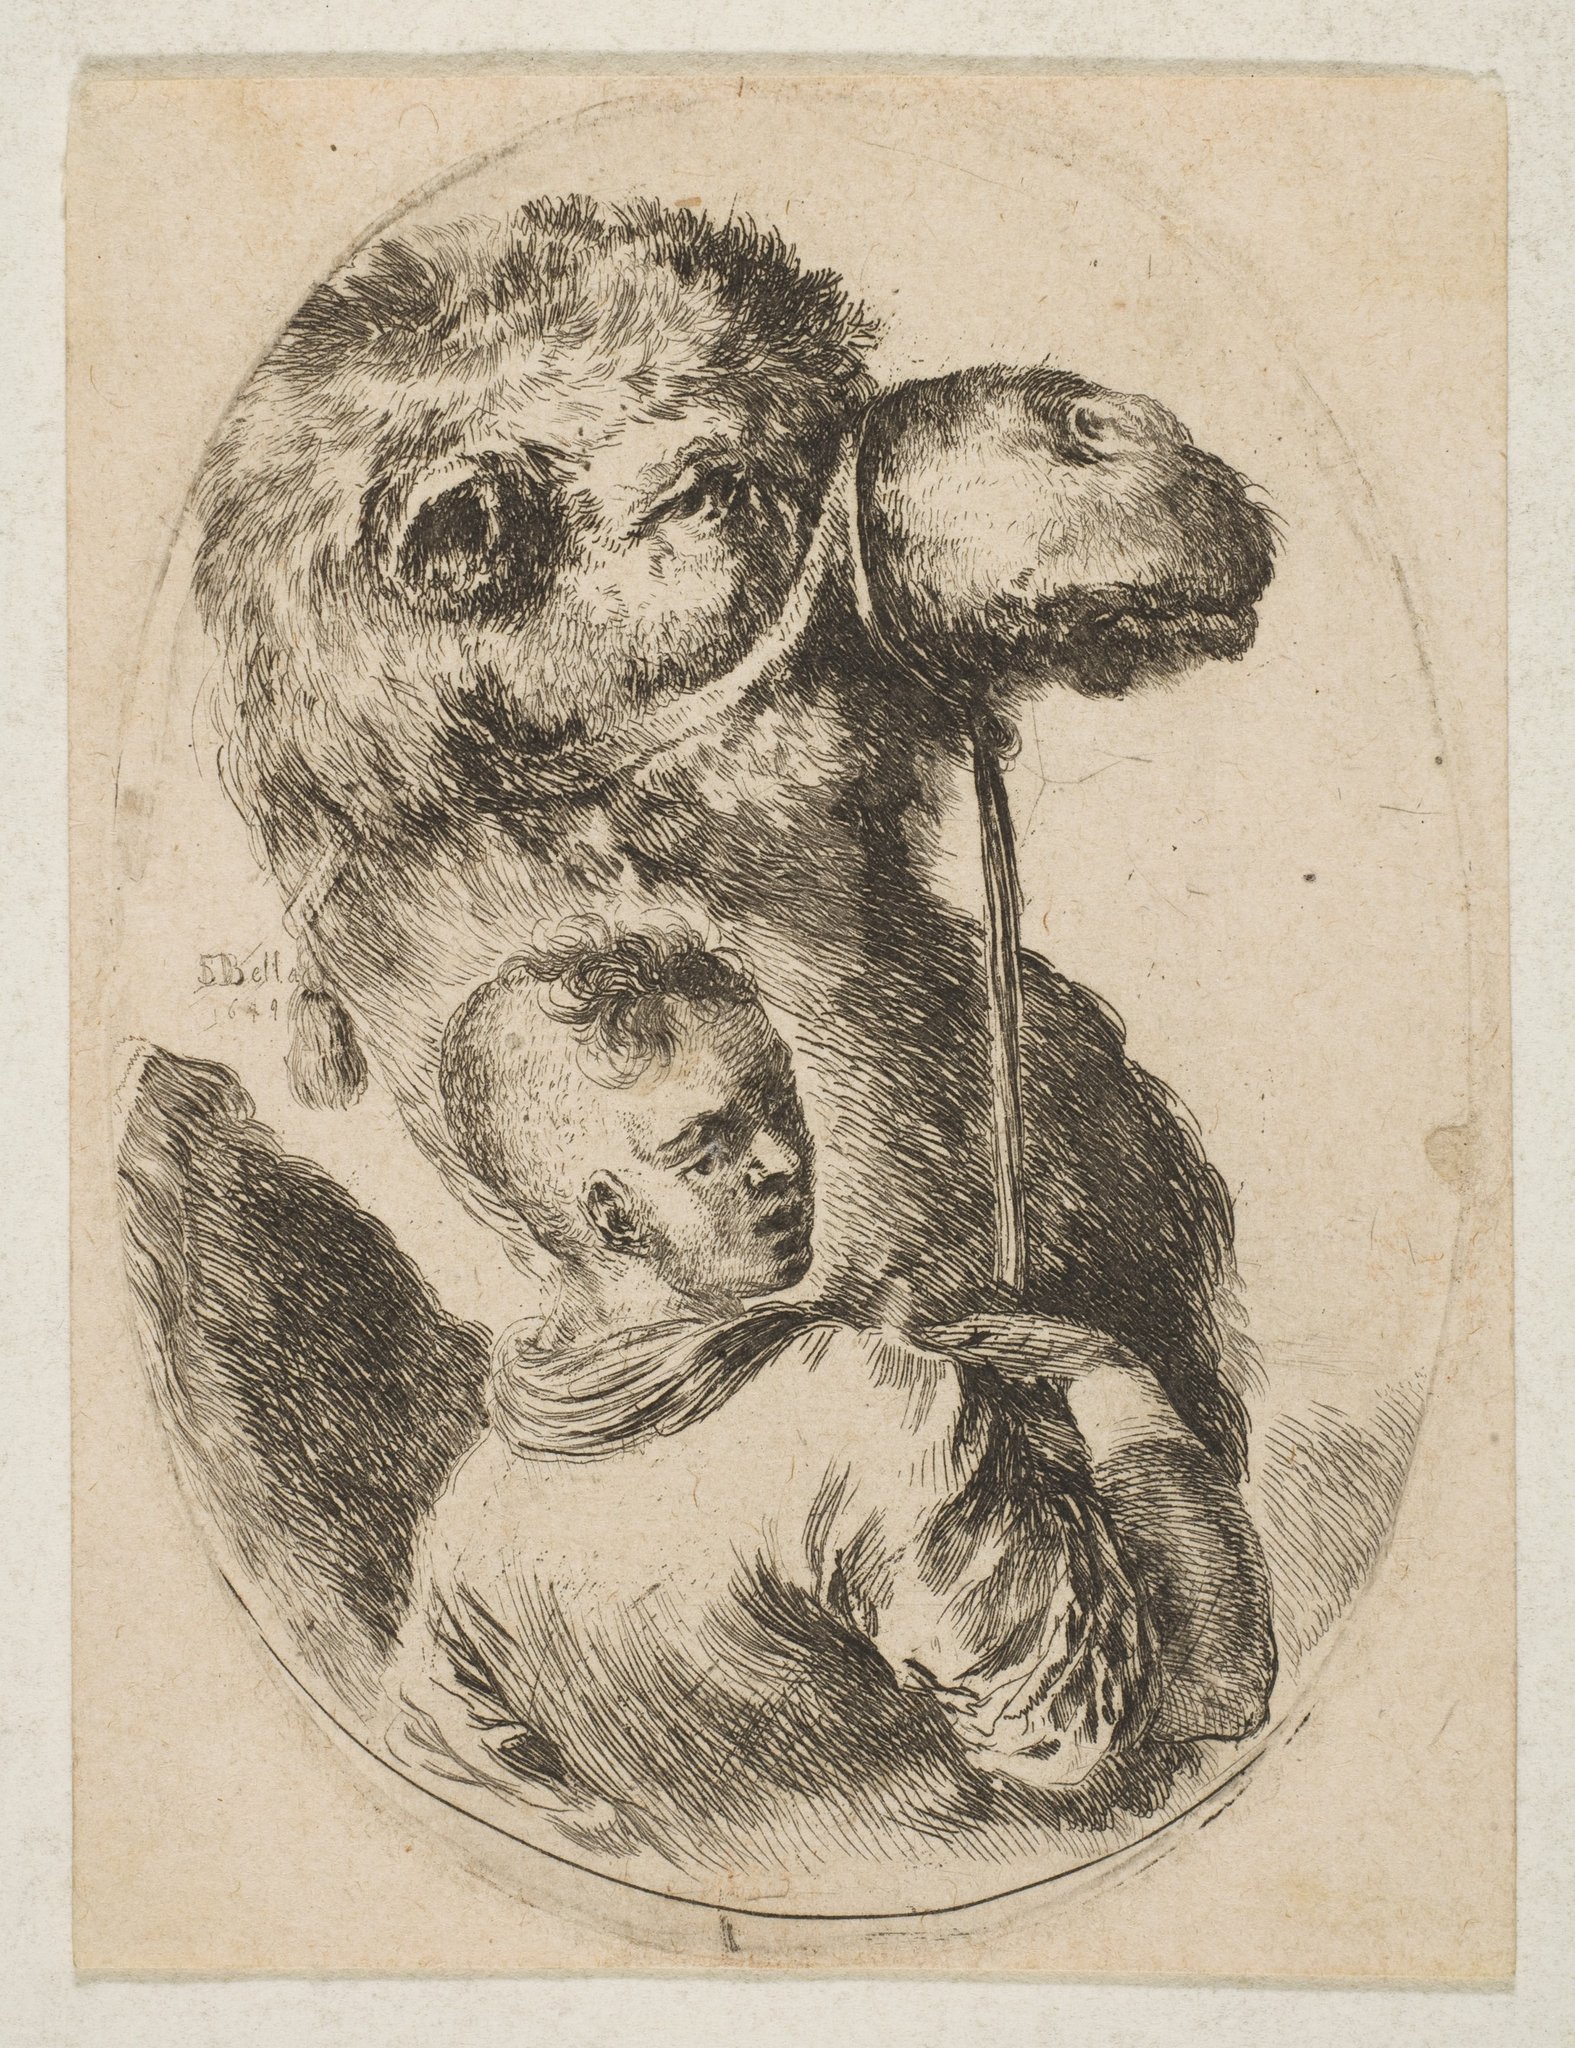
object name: print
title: A slave holds a camel by the bridle, from 'Several heads in the Persian style' (Plusieurs têtes coiffées à la persienne)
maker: stefano della bella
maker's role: artist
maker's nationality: italian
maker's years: 1610-1664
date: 1649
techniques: etching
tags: men,camels